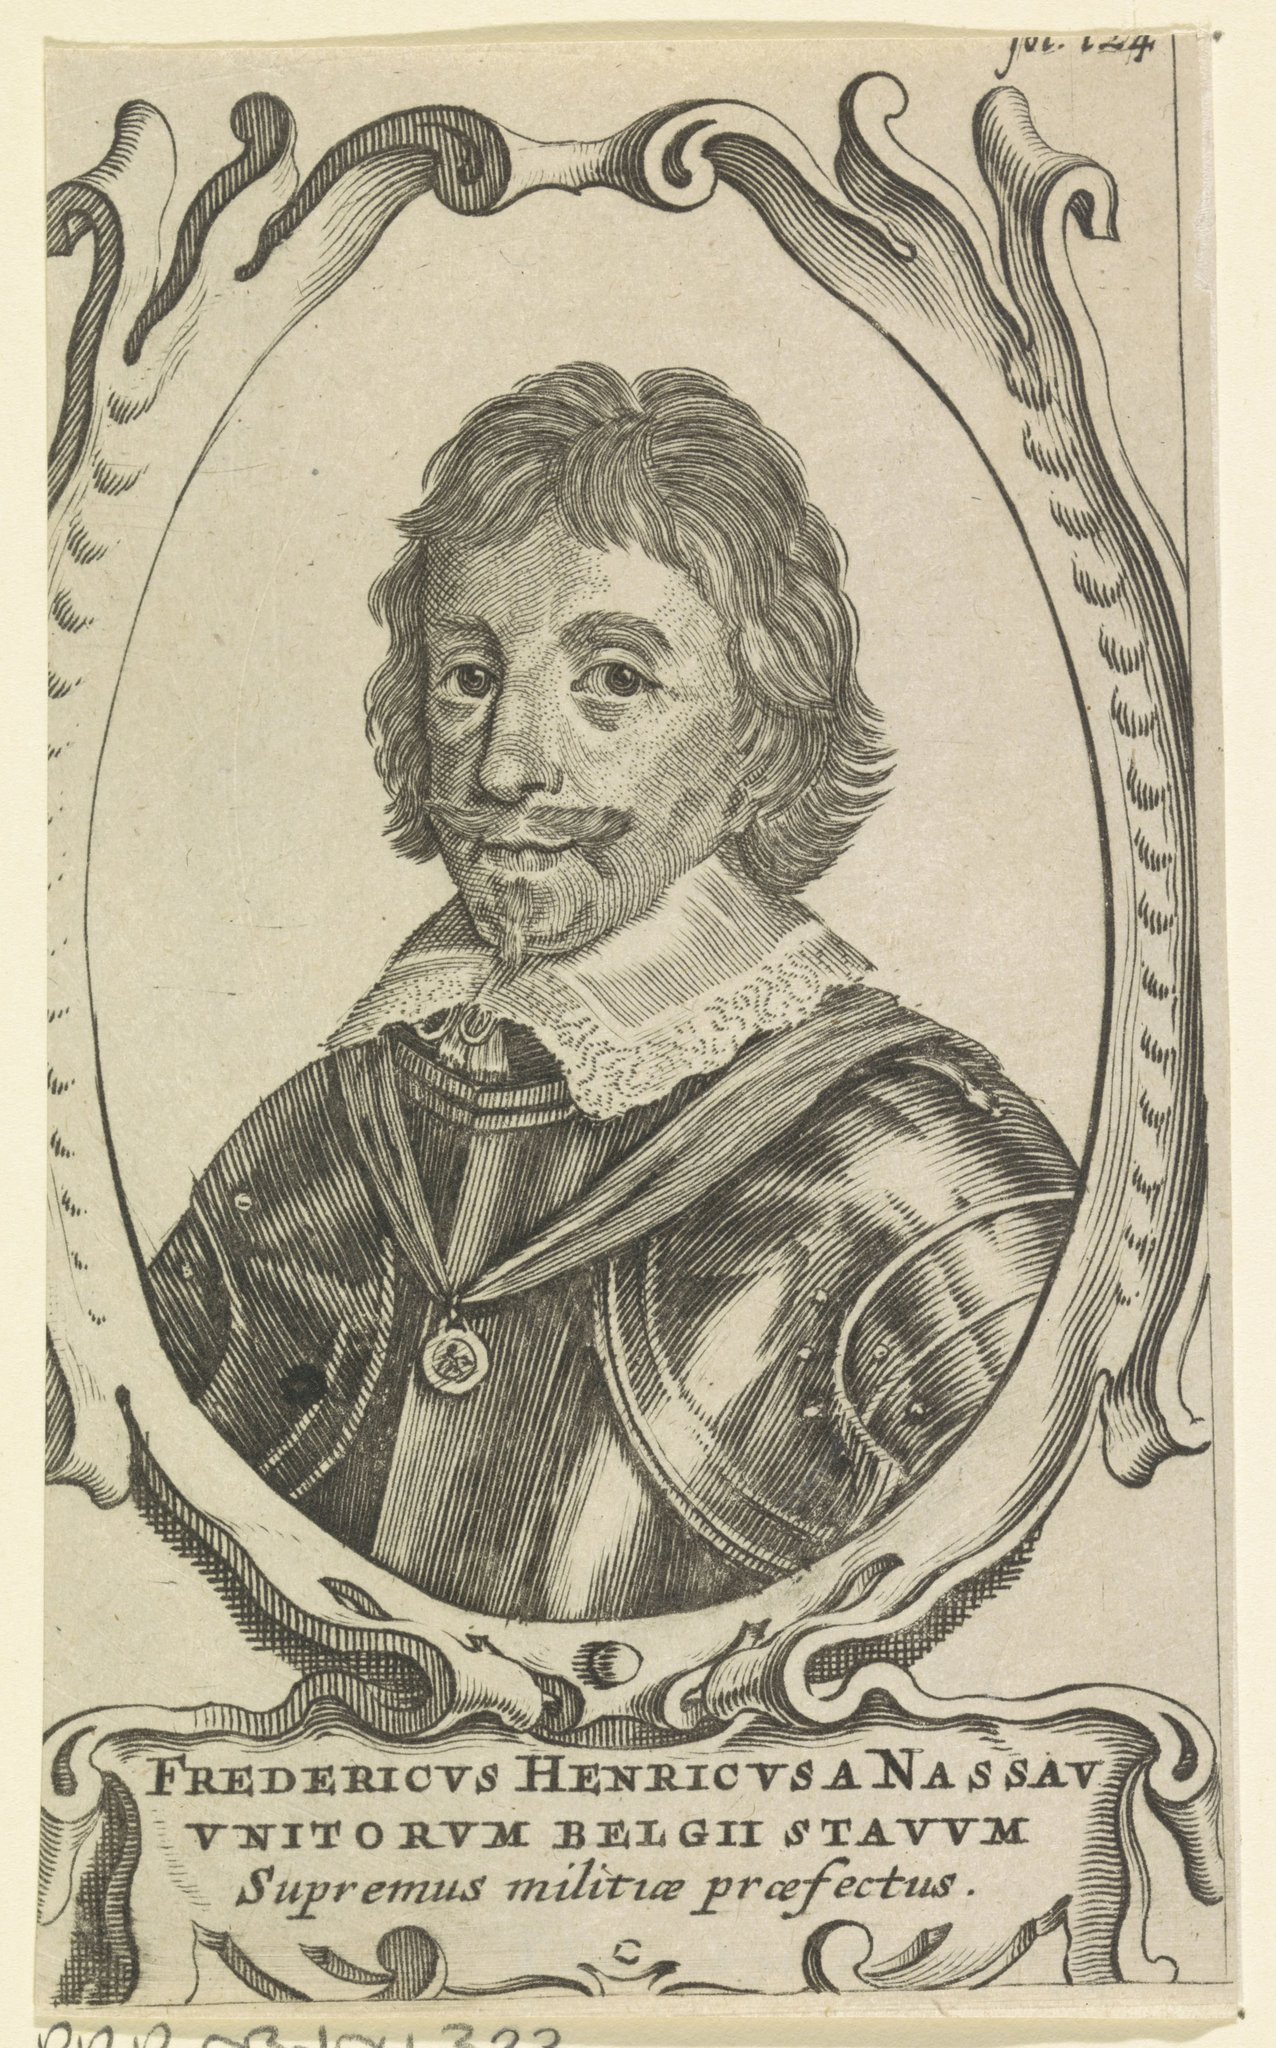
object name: print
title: Portret van Frederik Hendrik, prins van Oranje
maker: Anonymous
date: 1600-1699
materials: paper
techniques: engraving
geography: low countries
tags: delft, the hague, frederick henry (prince of orange), knighthood order (garter) - insignia of a knighthood order, e.g.: badge, chain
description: De hier vermelde titel verwijst naar de hoogst verkregen titel van de geportretteerde, niet per se naar de titel die de geportretteerde op deze voorstelling draagt.